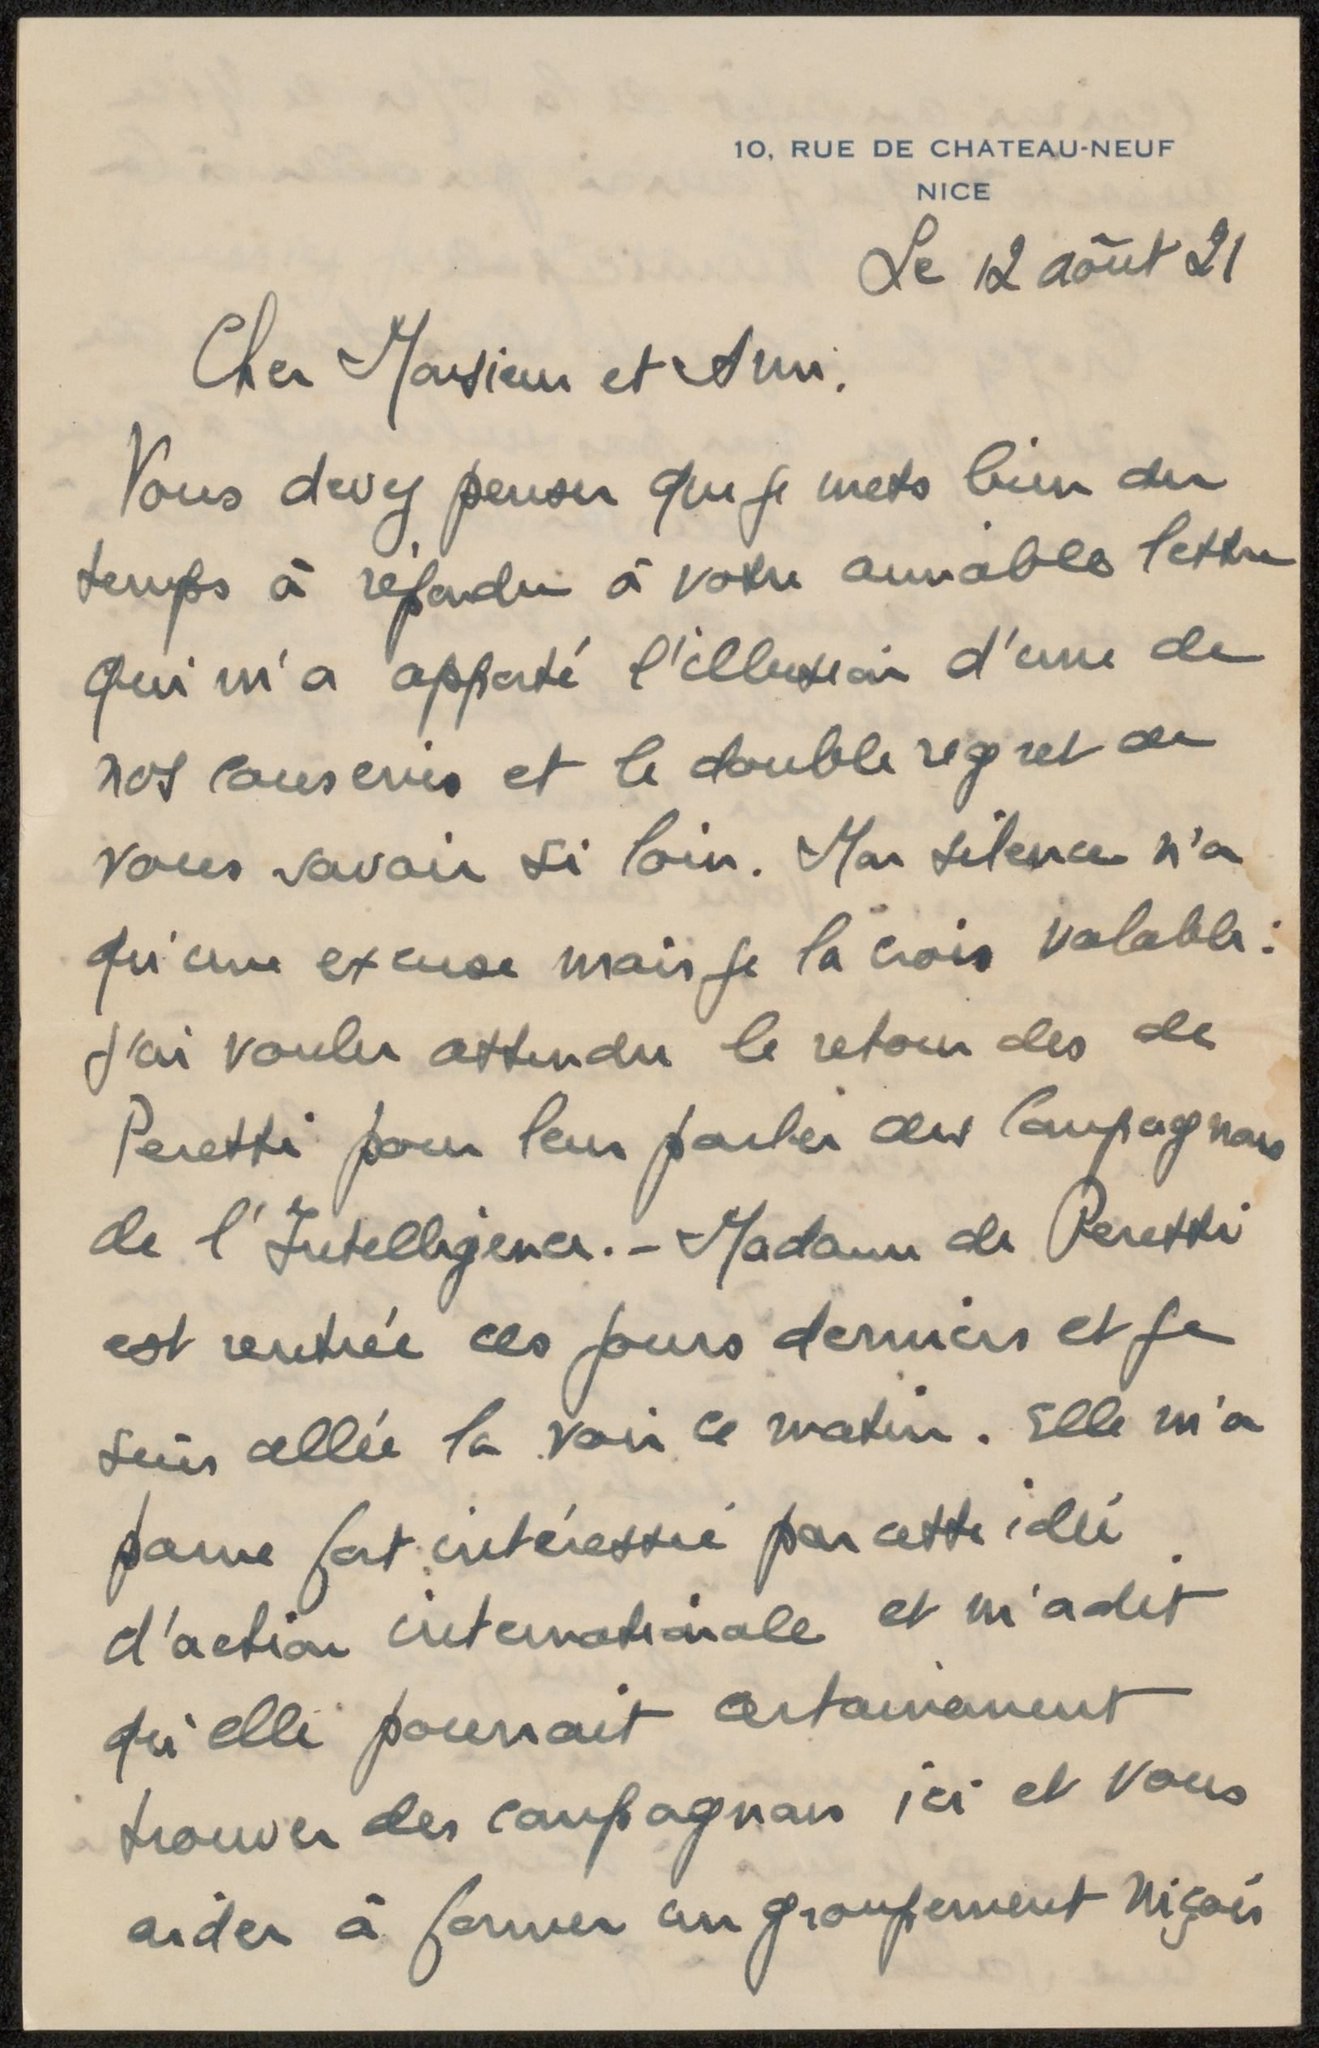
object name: letter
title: Brief aan Philip Zilcken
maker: jeanne erlich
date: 1921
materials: ink, paper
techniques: pen, printing, writing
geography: nice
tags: print maker, james abbott mcneill whistler, paris, paul verlaine, the hague, painter, draughtsman, philip zilcken, literature ~ arts, historical persons (portraits and scenes from the life), printed matter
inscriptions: collector's mark: ‘RPK’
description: Vormt samen met RP-D-1982-43-ERLICH(JEANNE)-14B een doorlopende brief.